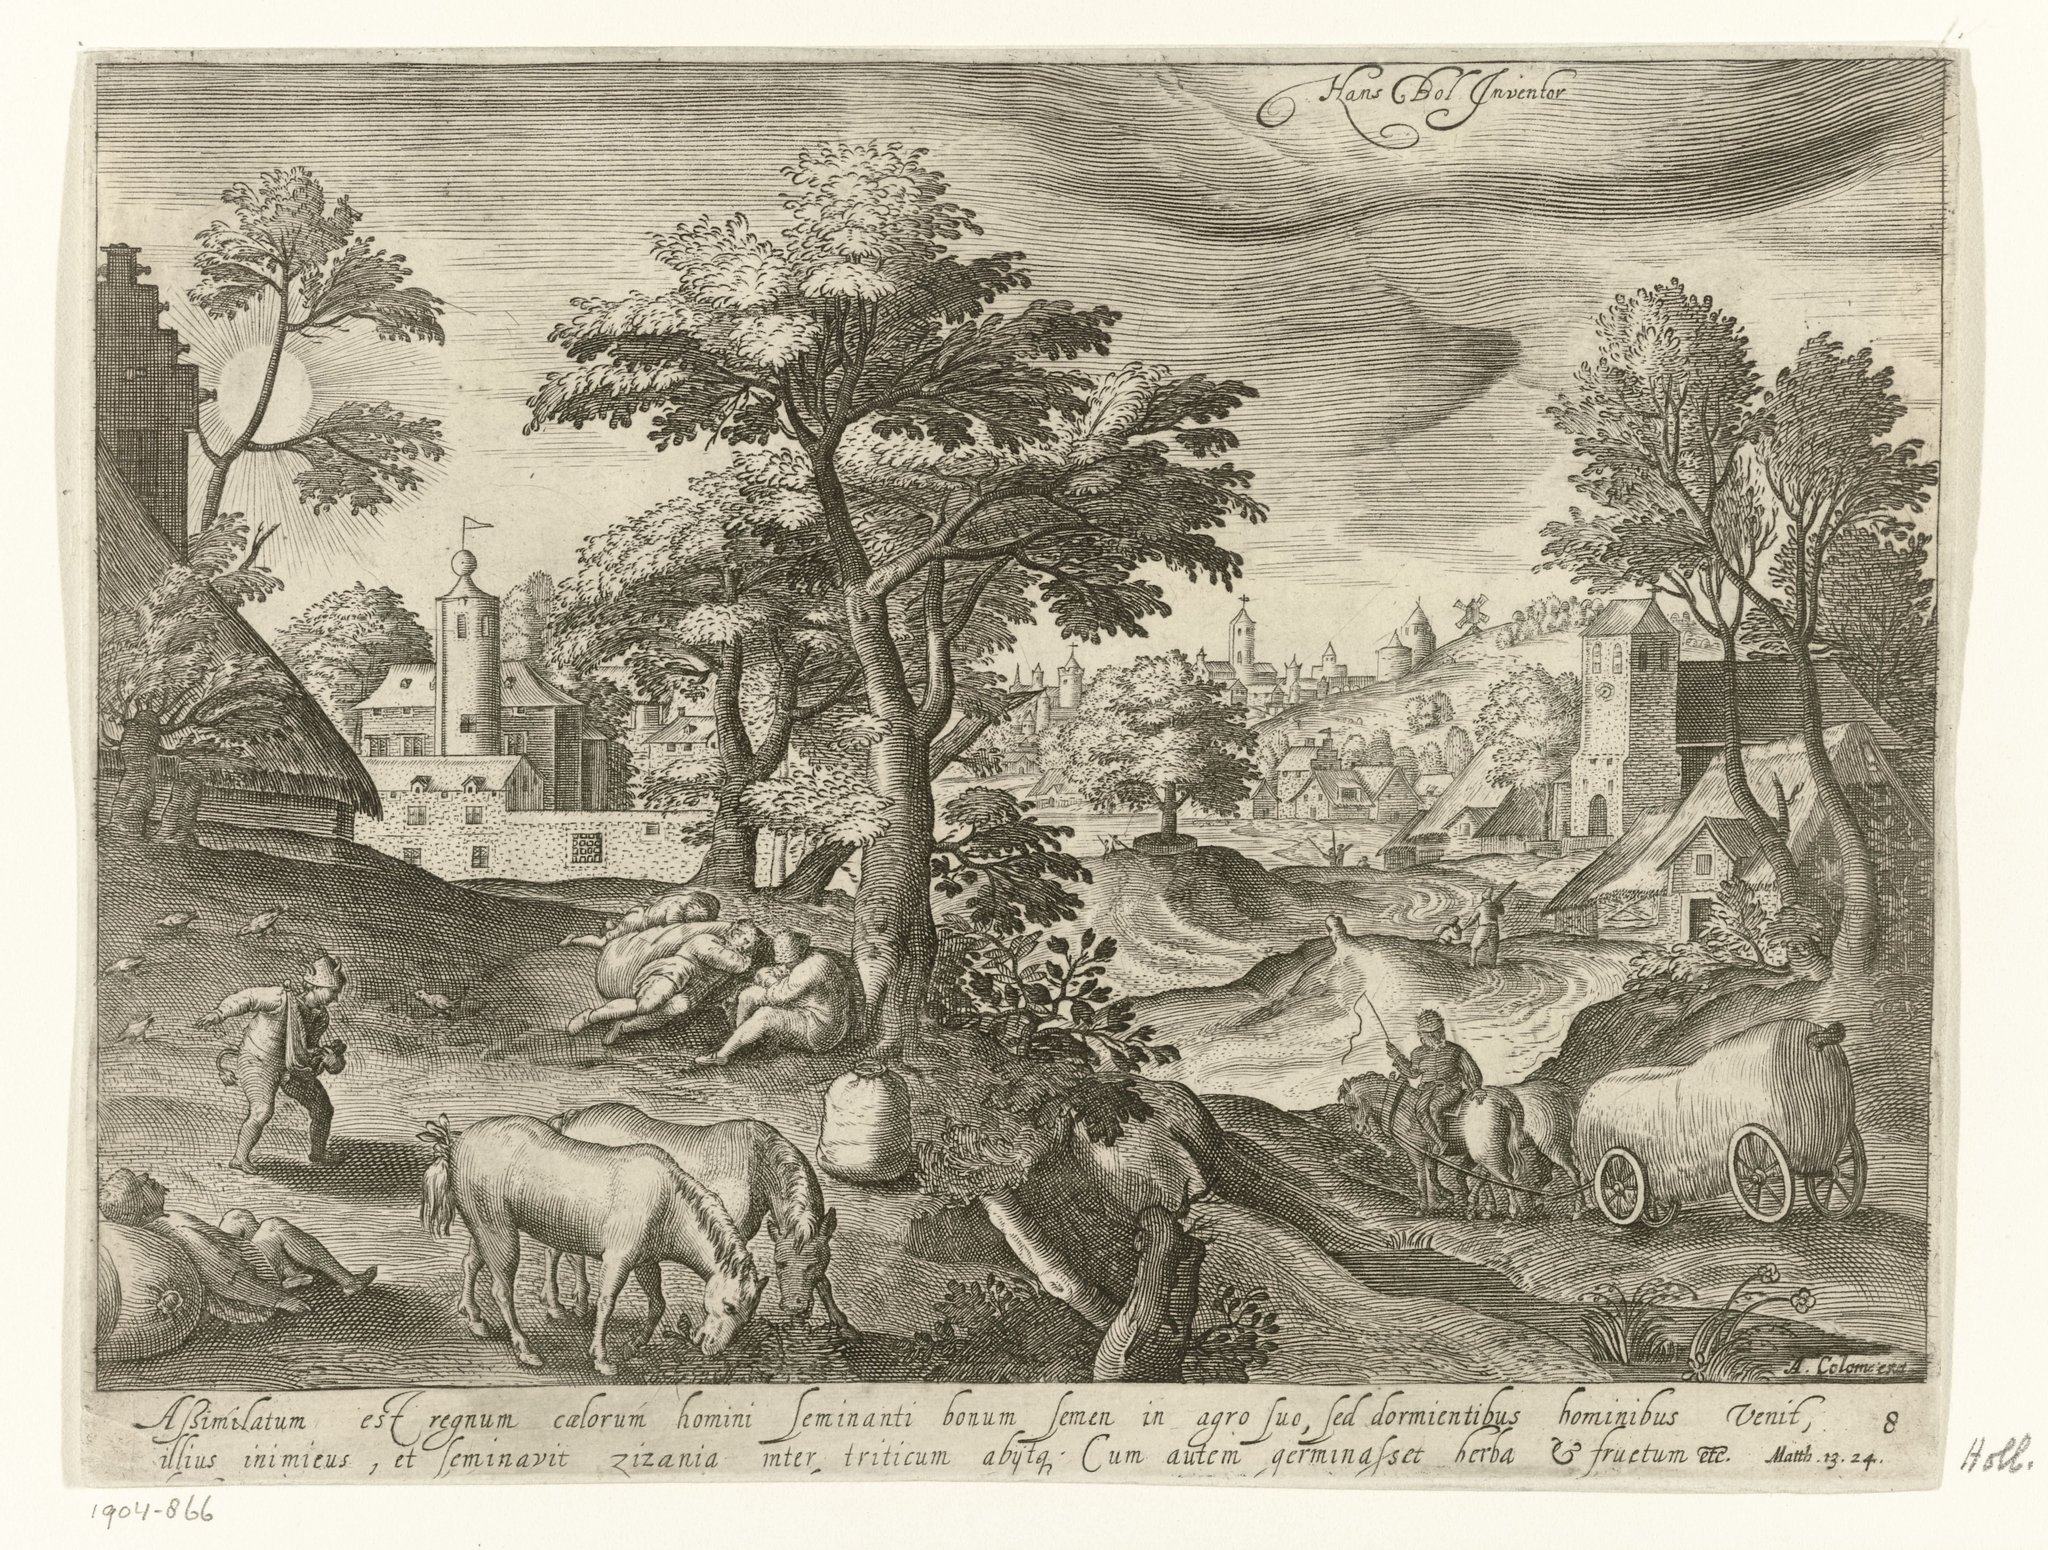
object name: print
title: Satan zaait onkruid tussen het graan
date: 1651-1658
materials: paper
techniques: engraving, etching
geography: low countries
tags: while the sower and his servants slept, his enemy (the devil) sowed tares among the wheat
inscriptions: collector's mark: Lugt 2228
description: Terwijl de landheer en zijn knechten slapen komt links de vijand van de landheer, de Duivel, om onkruid tussen het gezaaide graan te zaaien. Rechts rijdt een paard-en-wagen over een landweg in de richting van een dorp. Onder de voorstelling een tweeregelige verwijzing in het Latijn naar de Bijbeltekst in Mat. 13:24.